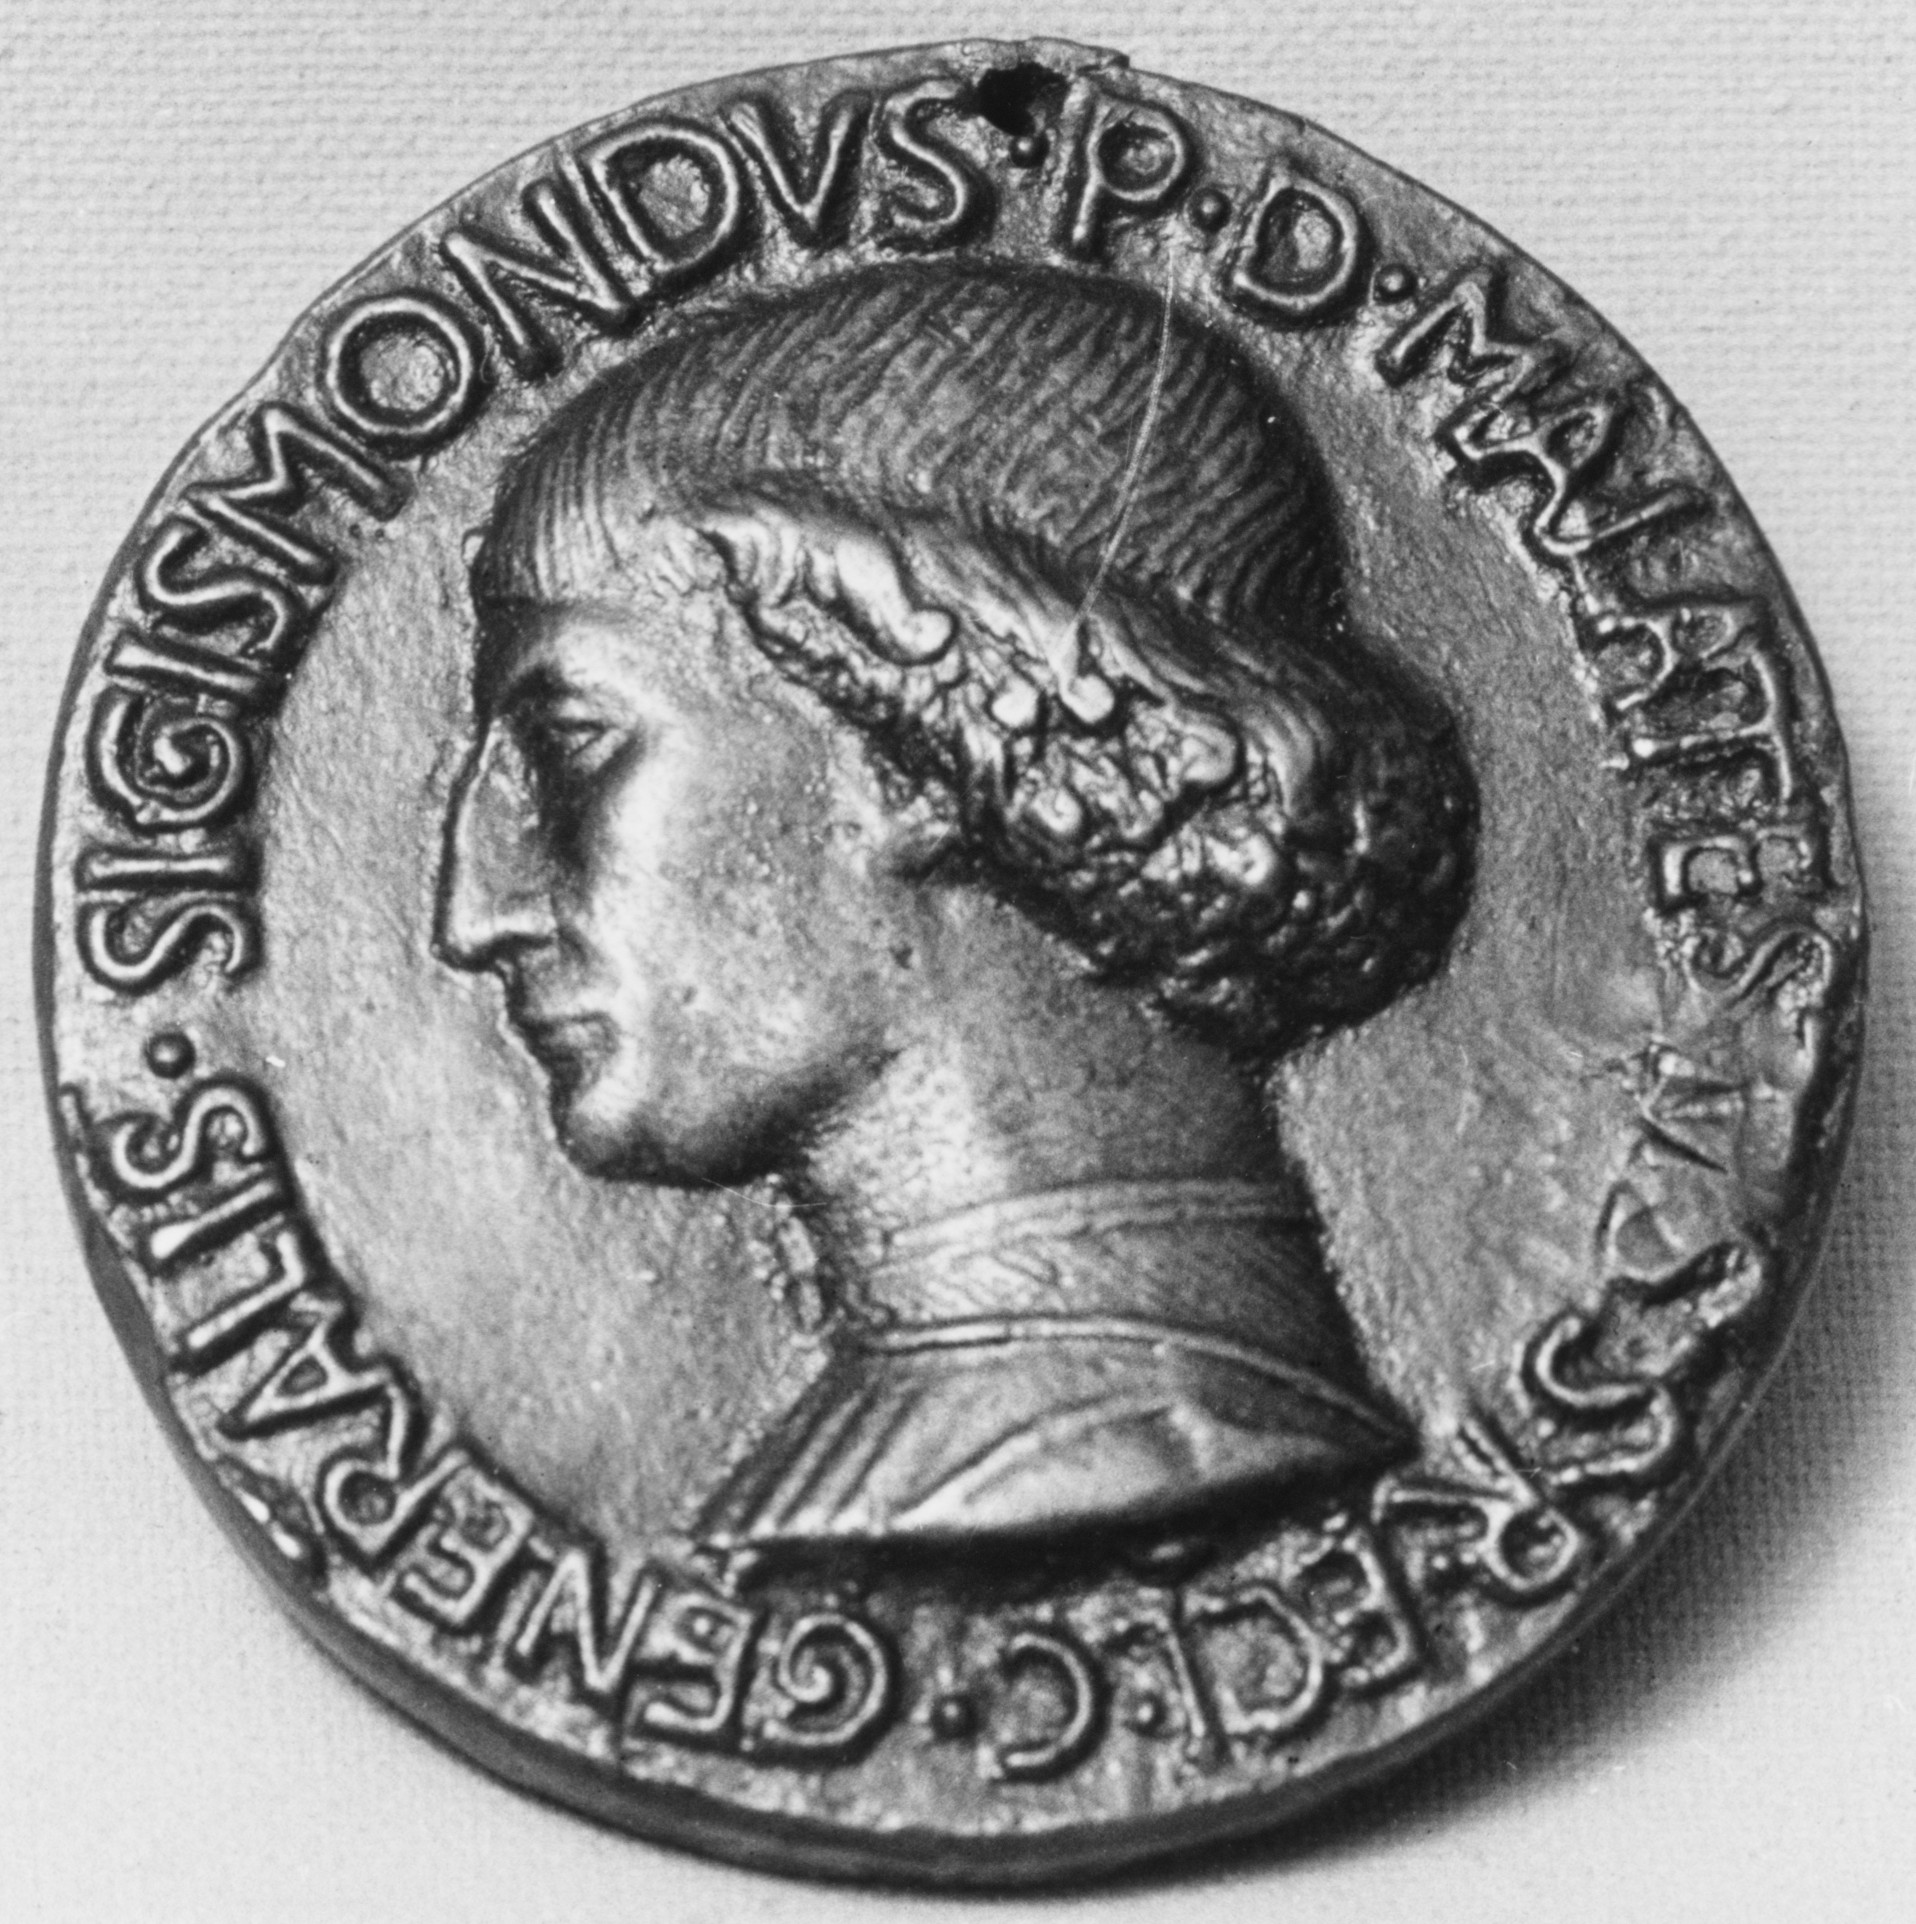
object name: medal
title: Sigismondo Malatesta as Captain of the Roman Church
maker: matteo de' pasti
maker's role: artist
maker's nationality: italian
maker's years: 1420-1467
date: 1446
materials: bronze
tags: men,profiles